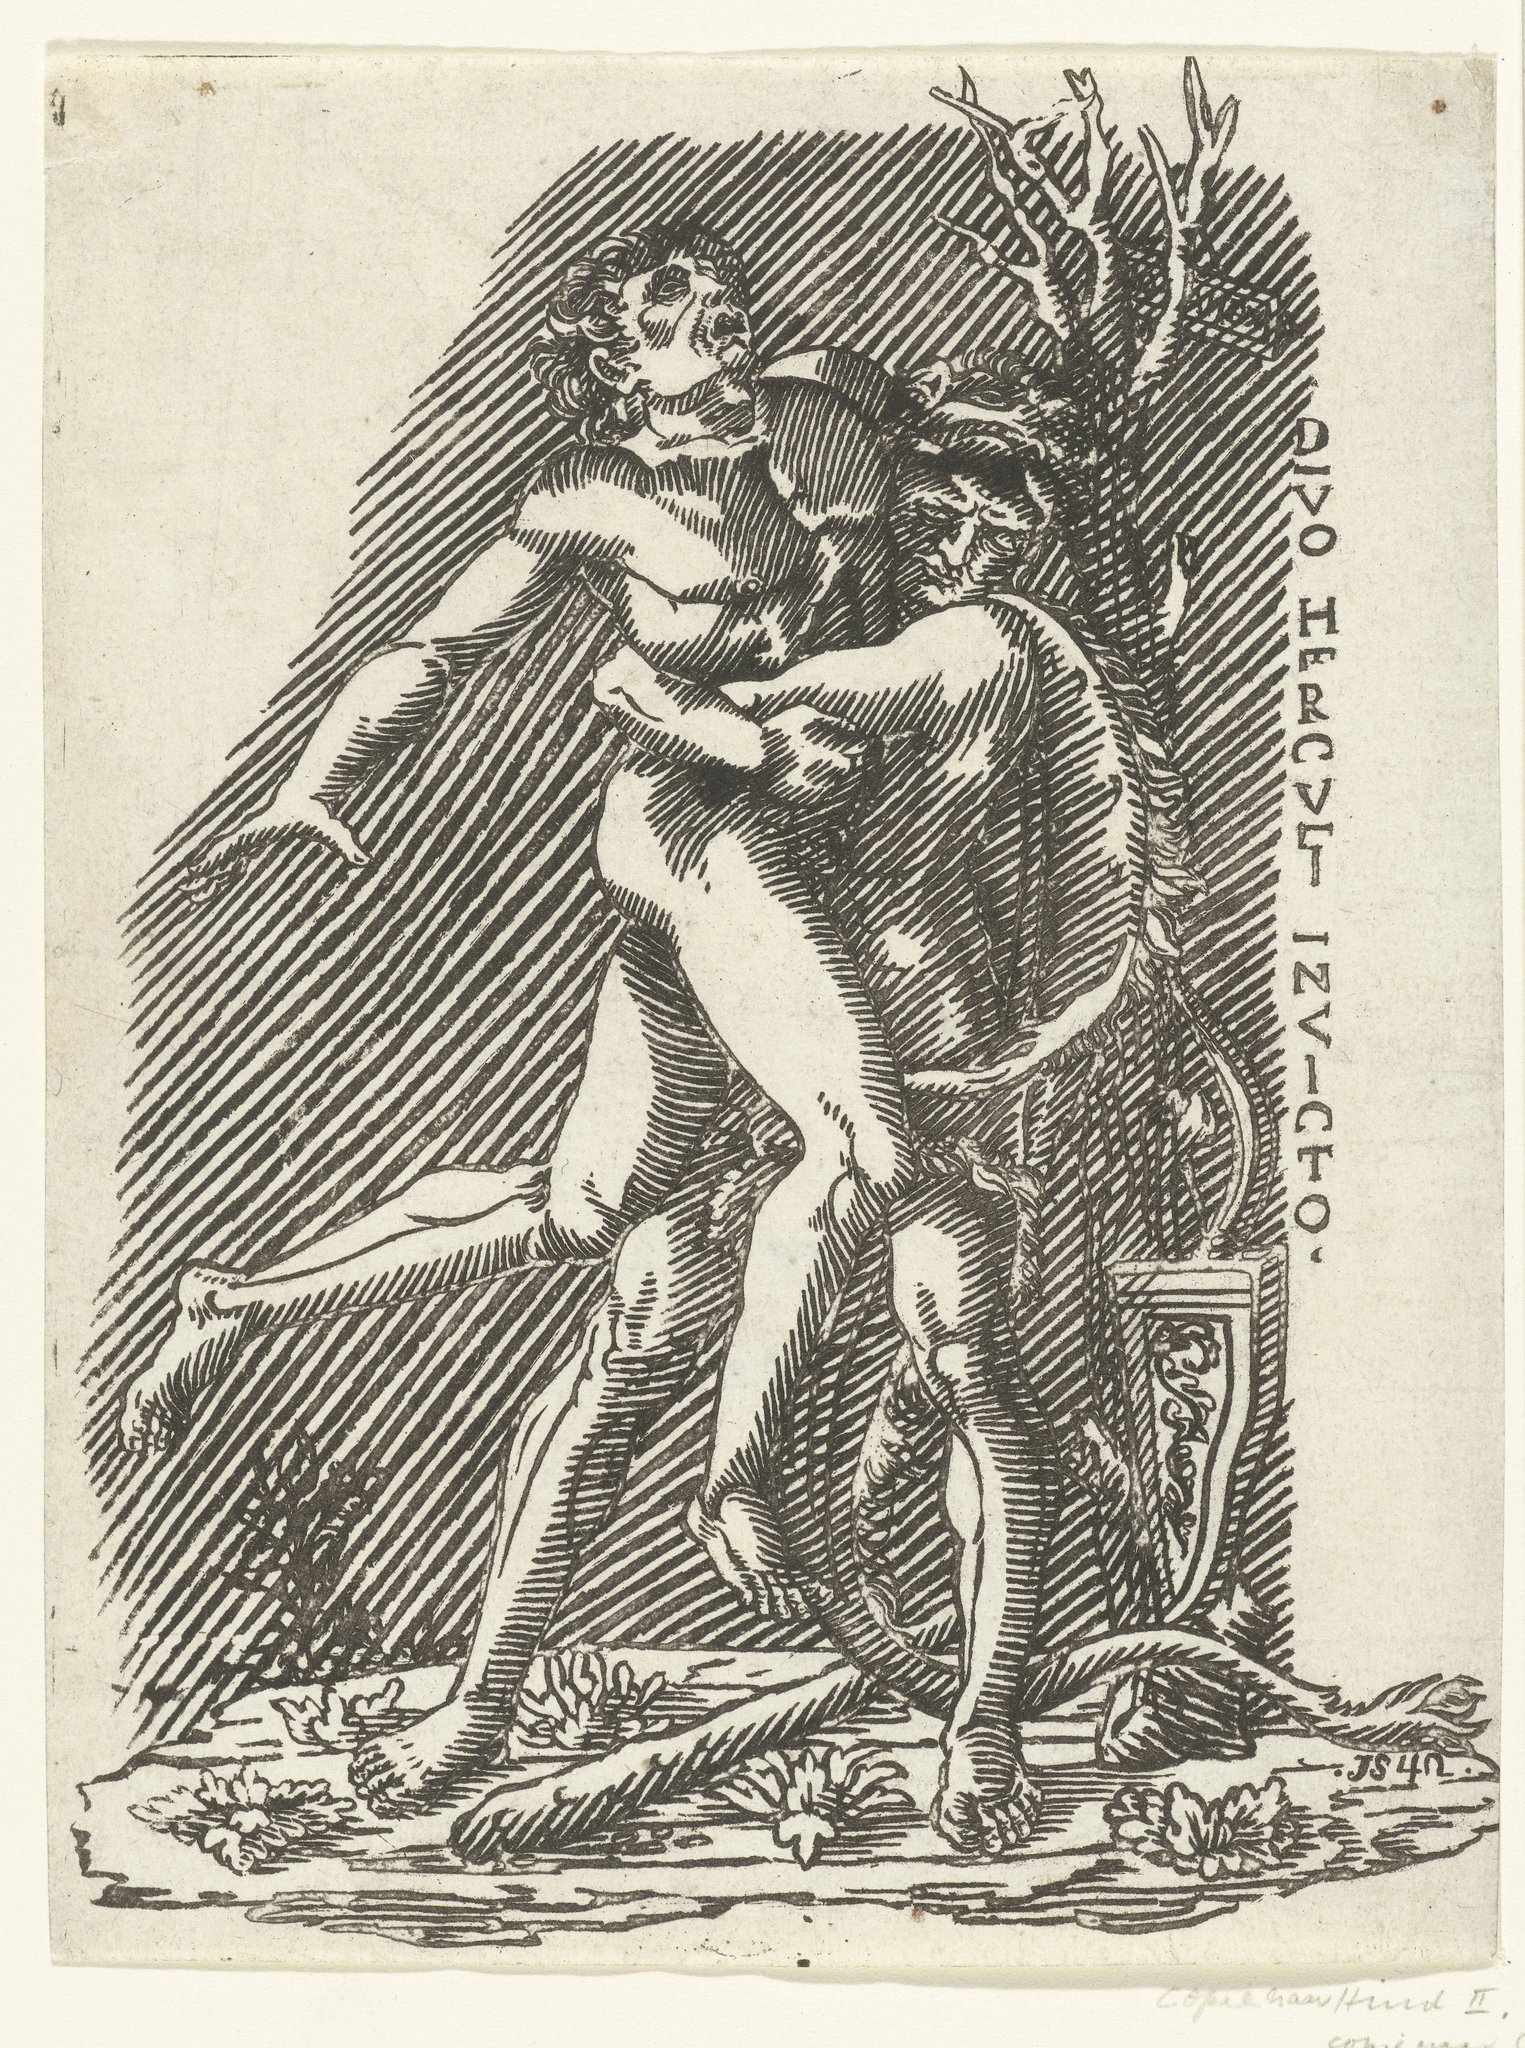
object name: print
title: Hercules en Antaeus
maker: Anonymous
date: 1700-1824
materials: paper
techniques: etching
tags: the giant antaeus is lifted in the air and crushed to death by hercules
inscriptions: collector's mark: Lugt 1904, collector's mark: Lugt 2228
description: Ets naar prent van Giovanni Antonio da Brescia, die op zijn beurt weer geïnspireerd werd door een prent uit de School van Mantegna (zie documentatie). Etstechniek toegepast als imitatie houtsnede techniek.